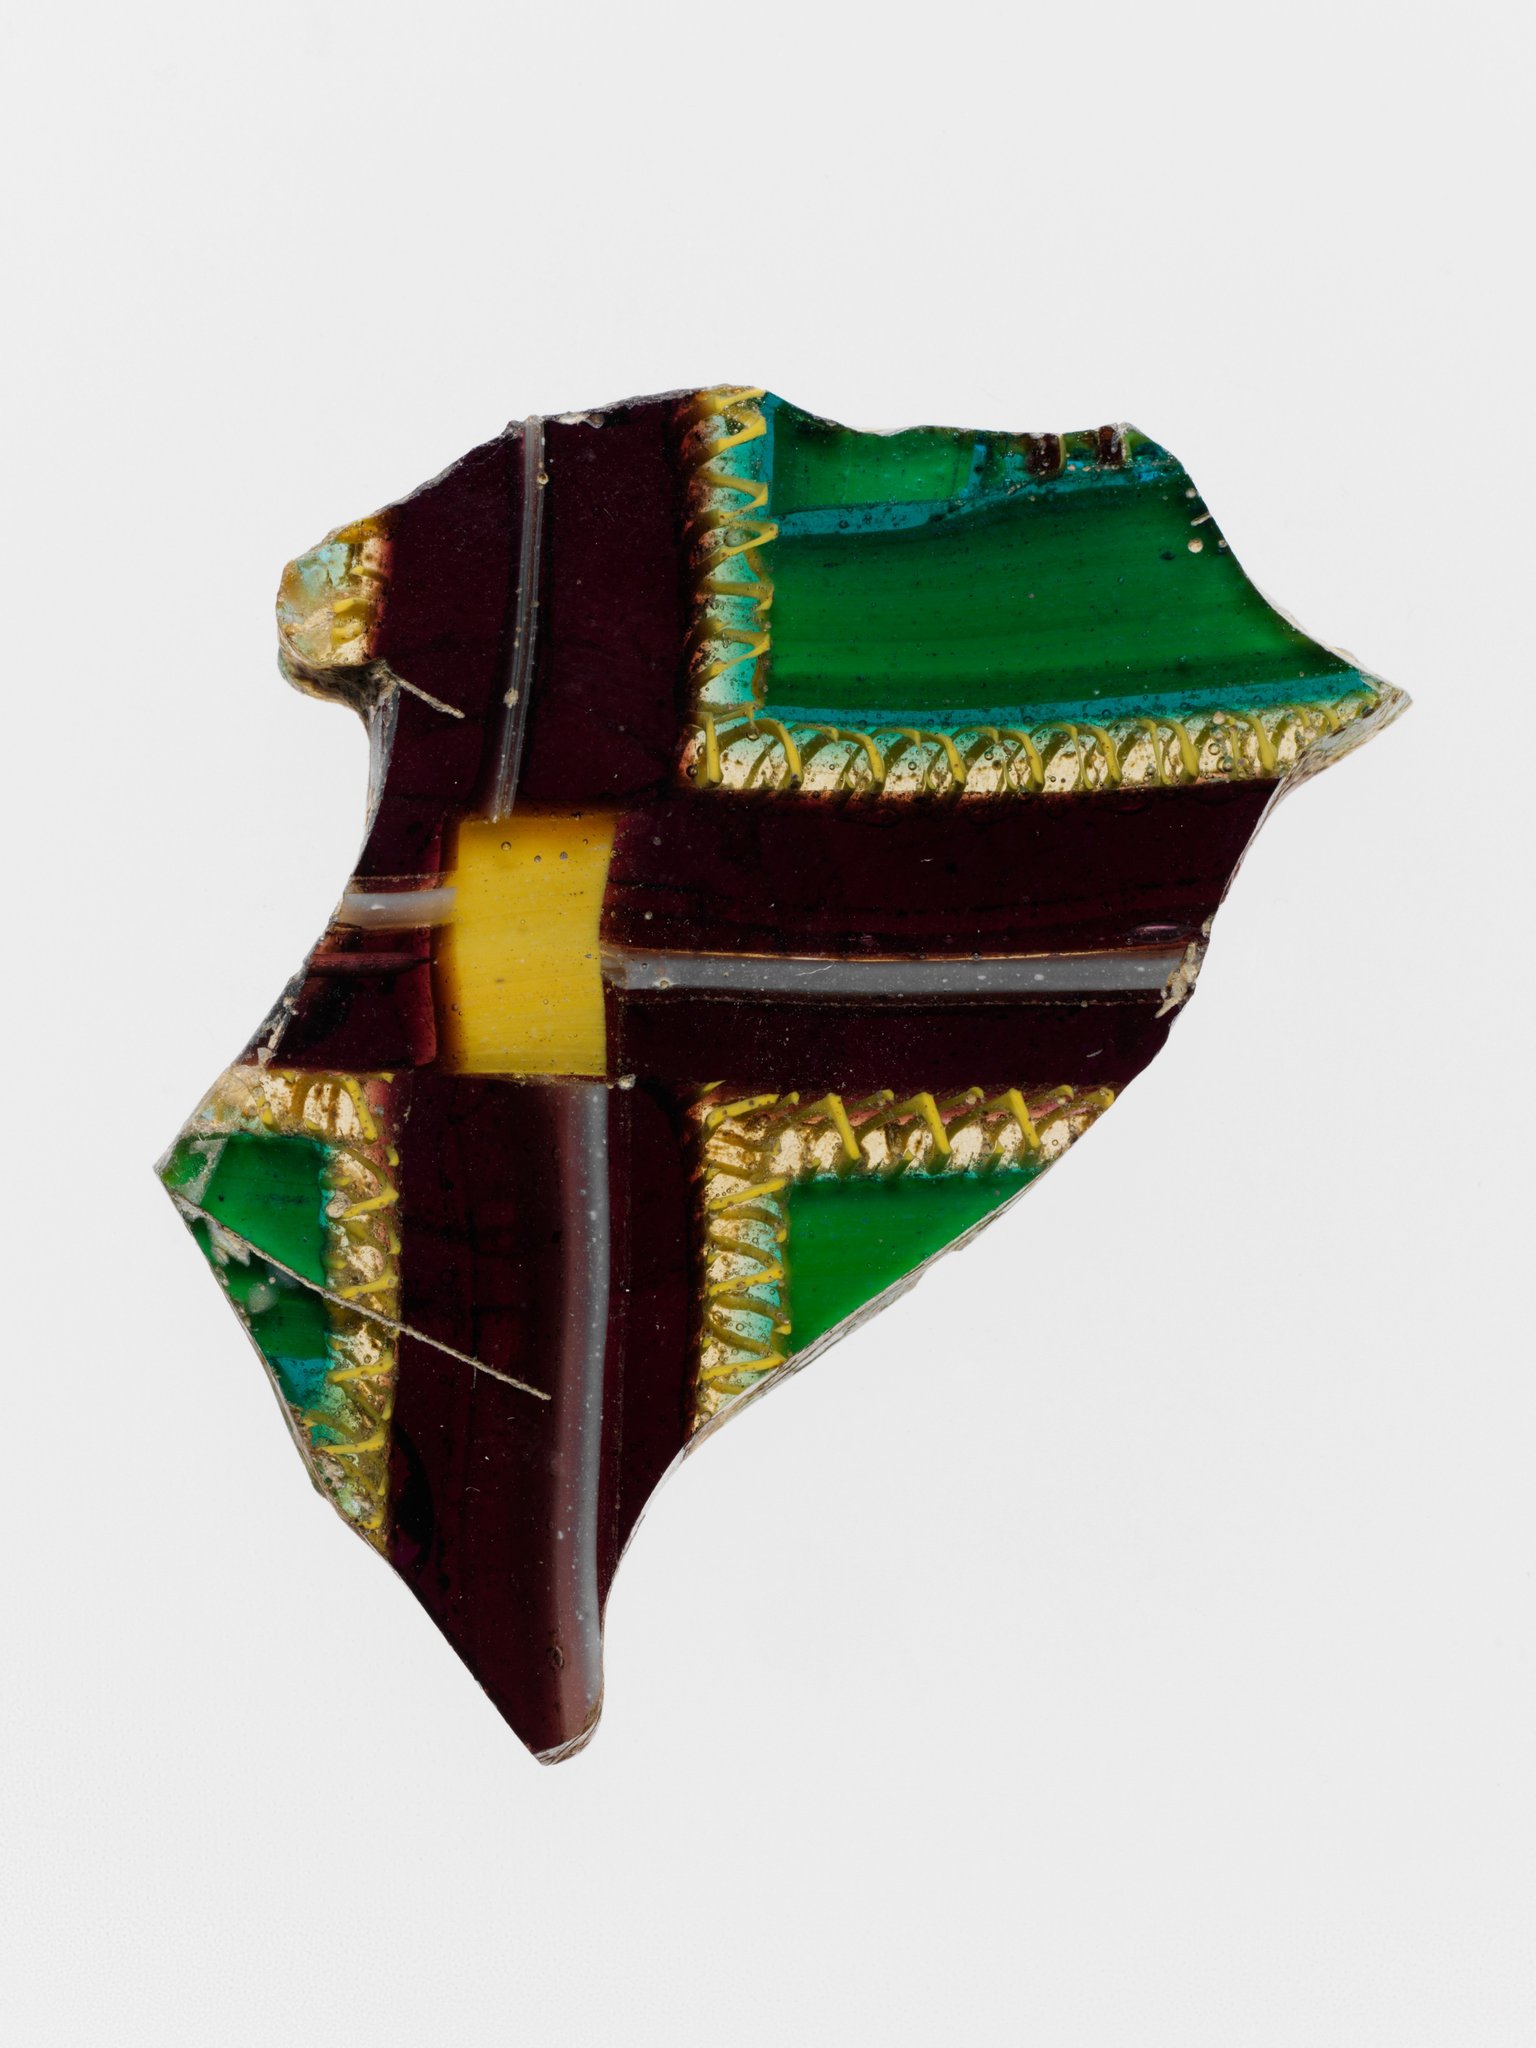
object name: fragment, striped mosaic, quadripartite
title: Glass striped mosaic fragment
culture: roman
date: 34 BCE-33 CE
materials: glass